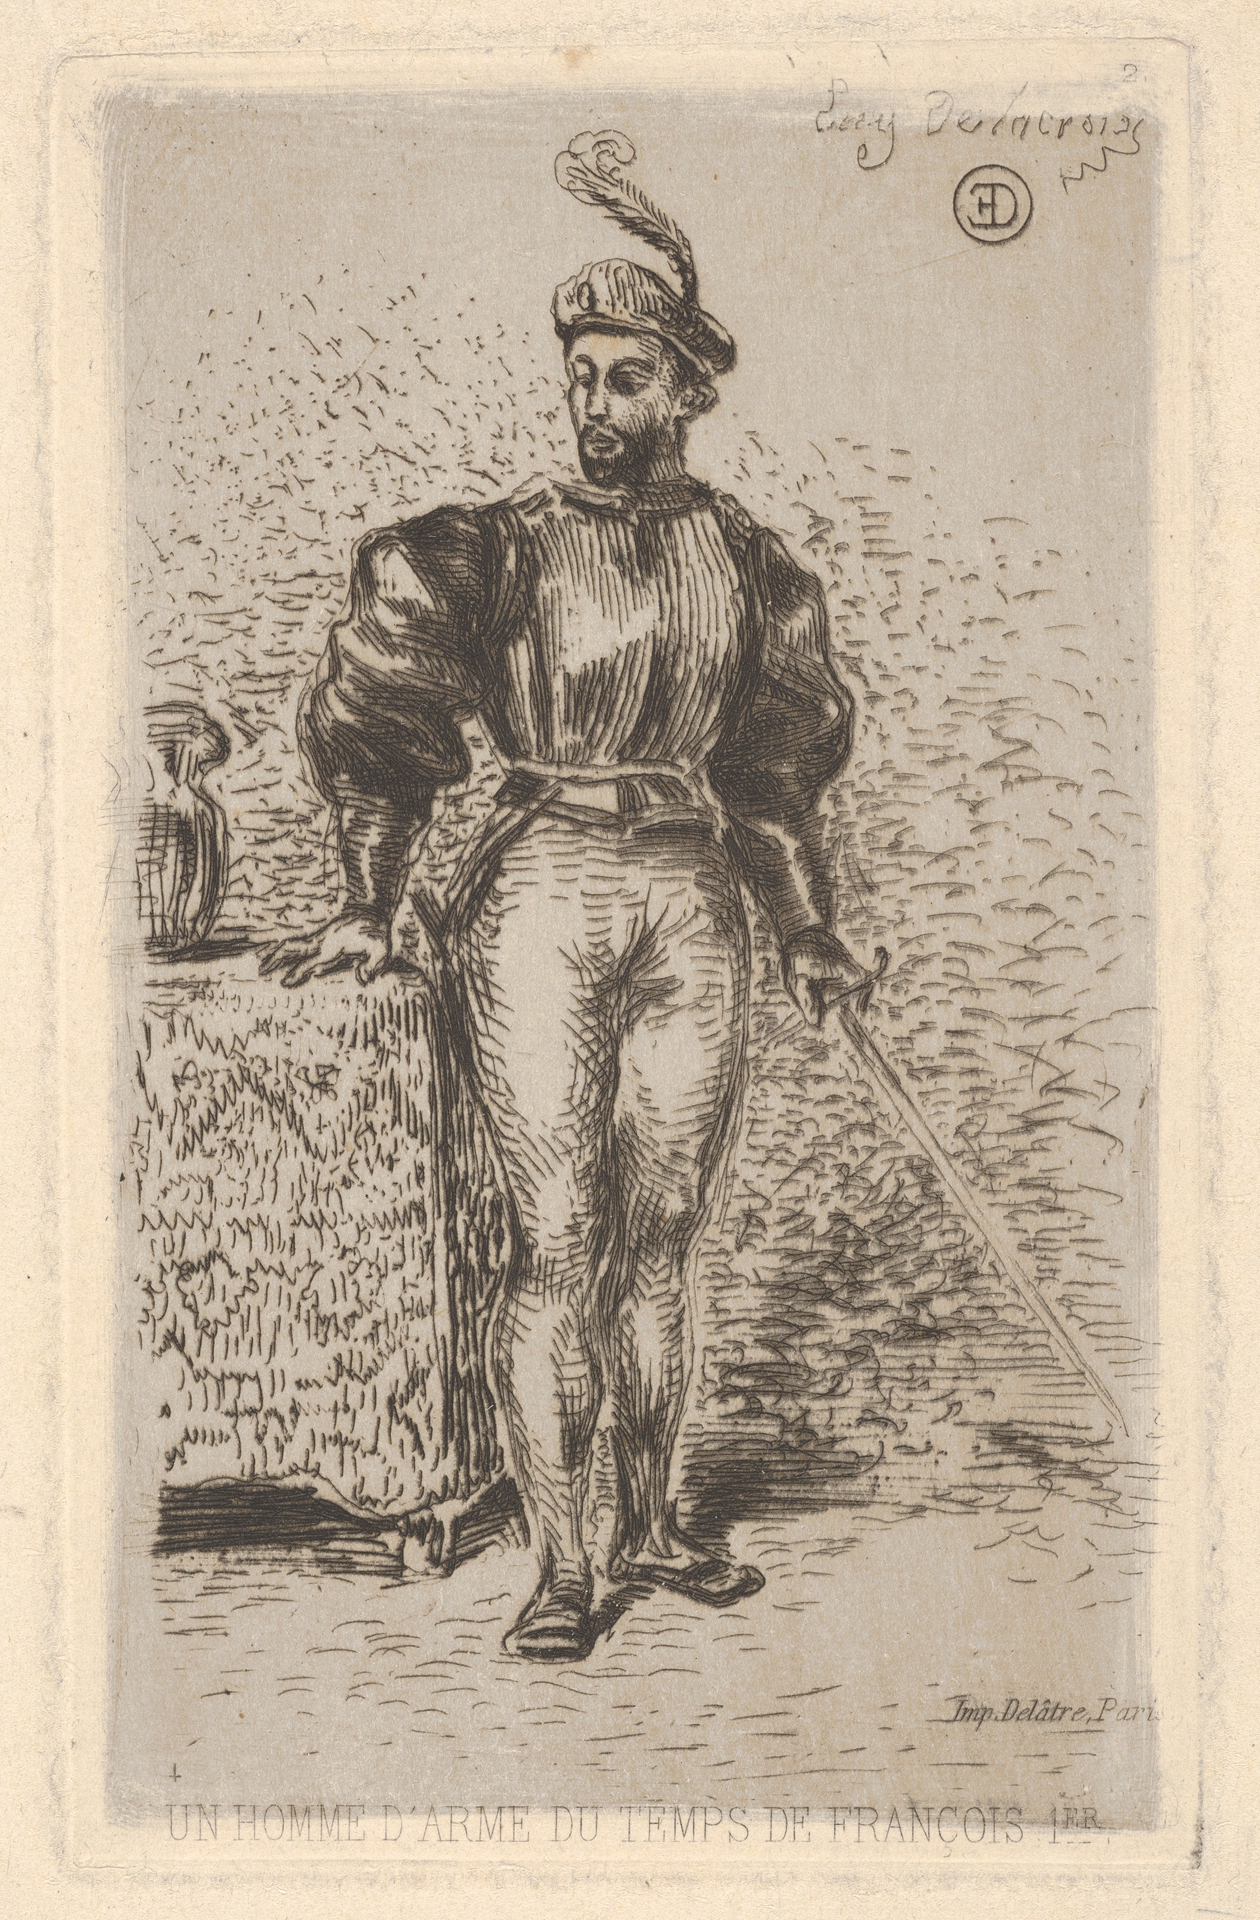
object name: print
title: Man at Arms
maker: eugène delacroix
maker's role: artist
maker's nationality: french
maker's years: 1798-1863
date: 1801-1900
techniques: drypoint, etching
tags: swords,men